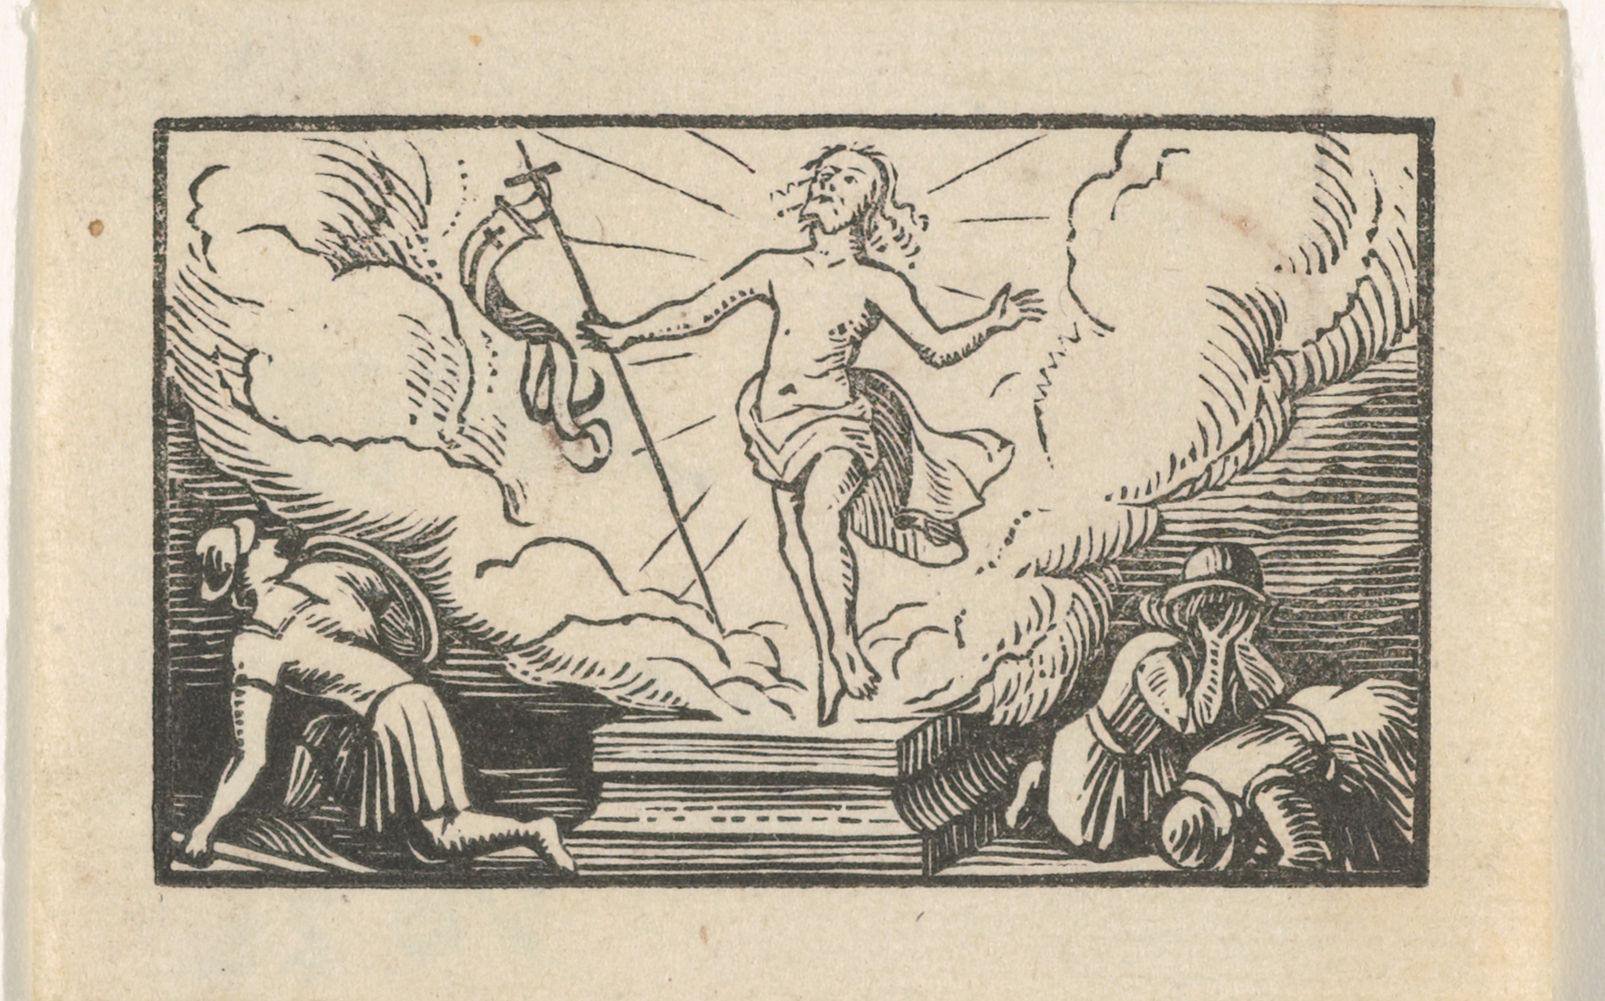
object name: print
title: Voorstellingen uit het Nieuwe Testament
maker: dirck de bray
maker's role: draughtsman, painter, print maker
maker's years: 1625-1694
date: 1635-1694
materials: paper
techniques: woodcut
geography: netherlands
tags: christ, usually holding a banner, arises from the grave; often combined with sleeping and/or frightened soldiers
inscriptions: collector's mark: Lugt 240